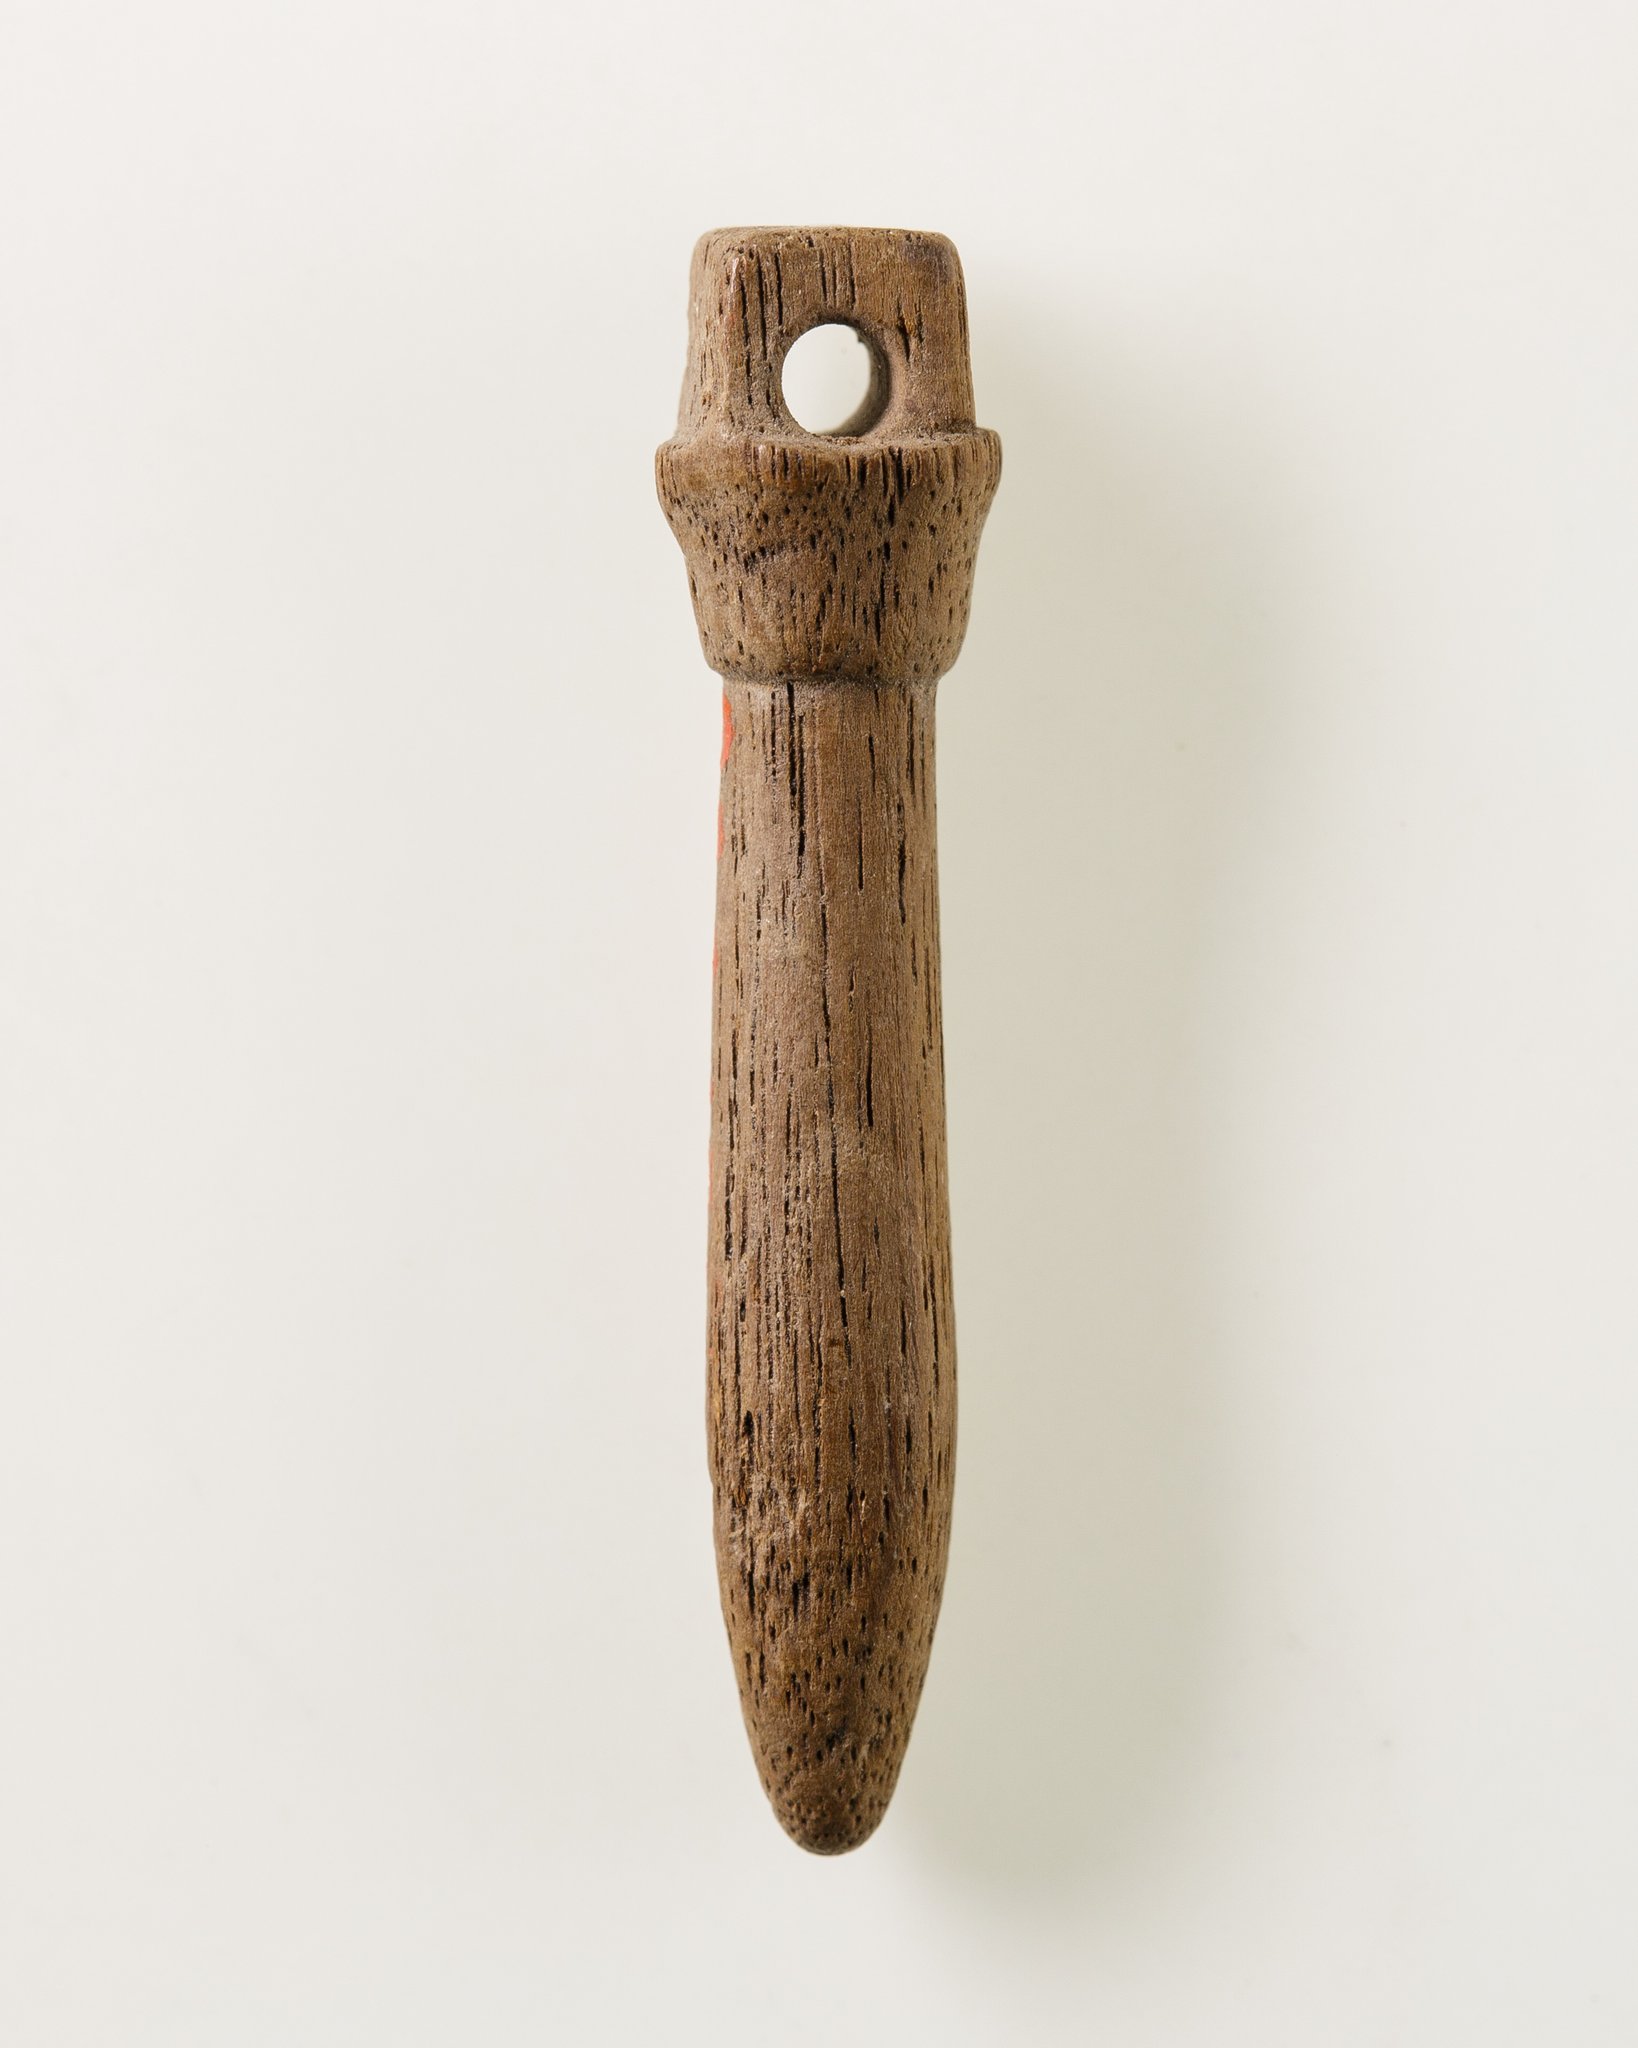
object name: amulet, papyrus scepter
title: Papyrus Column (wadj) Amulet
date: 712-332 BCE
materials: wood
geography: egypt